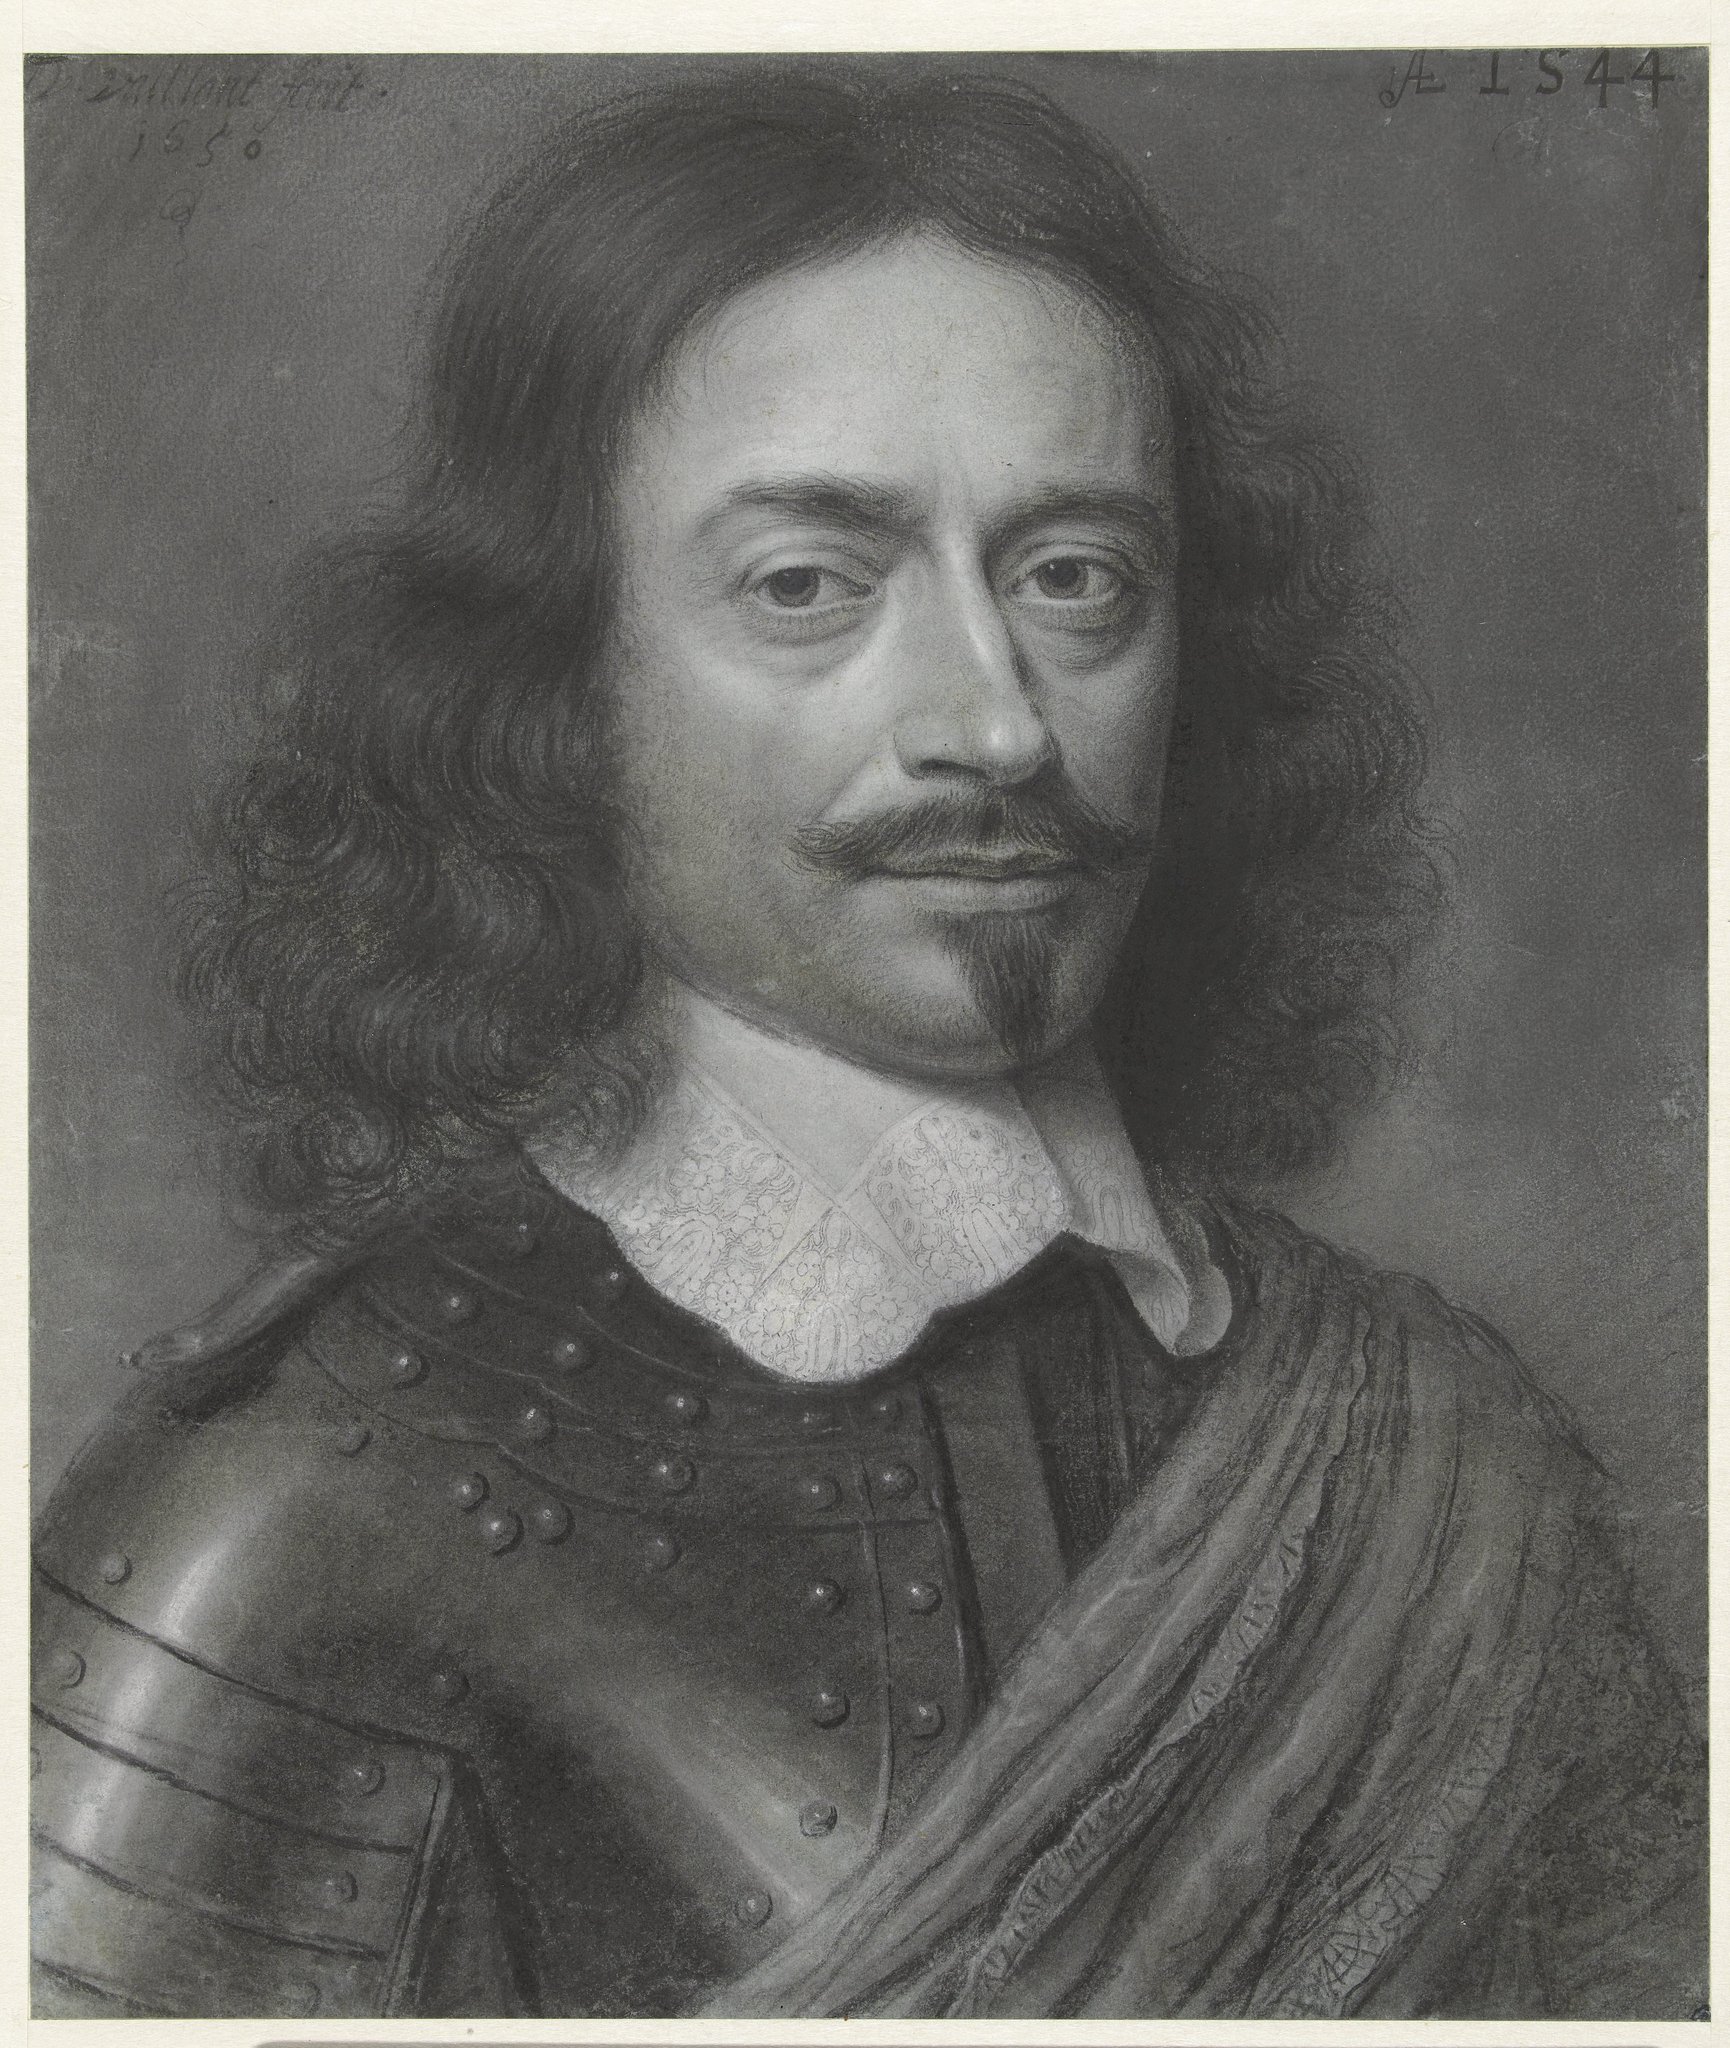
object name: drawing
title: Portret van een man op 44-jarige leeftijd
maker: wallerant vaillant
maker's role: draughtsman, painter, print maker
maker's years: 1623-1677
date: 1650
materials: chalk, paper, pencil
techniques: brush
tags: anonymous historical person portrayed alone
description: Pendant van 'Portret van vrouw op 43-jarige leeftijd'.